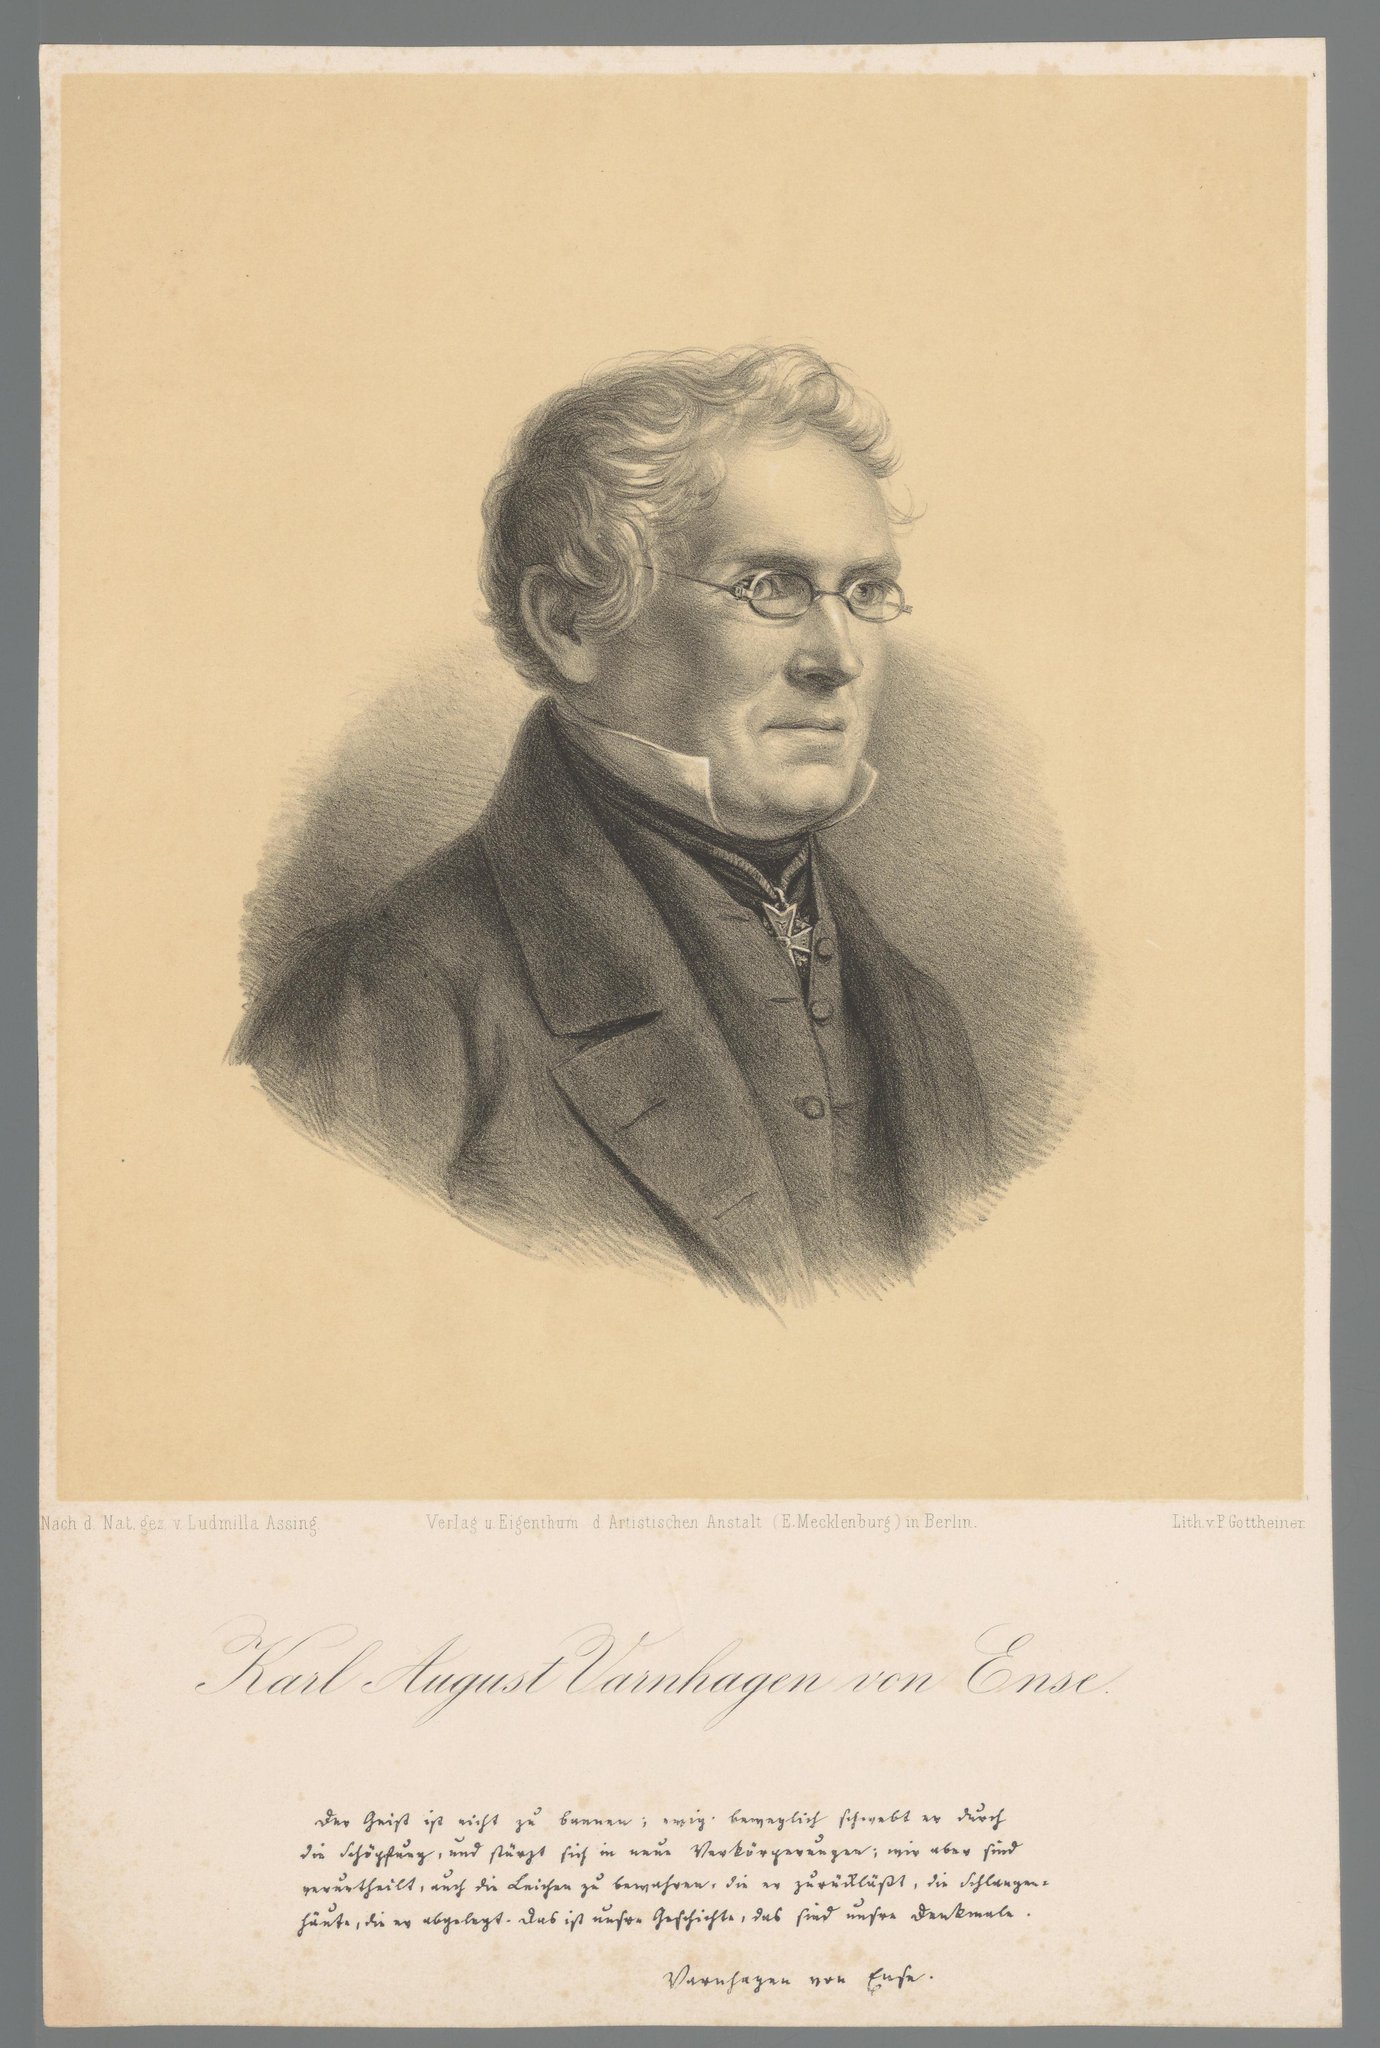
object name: print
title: Portret van Karl August Varnhagen von Ense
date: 1831-1880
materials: paper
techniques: lithograph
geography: berlin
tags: historical persons, diplomacy, diplomat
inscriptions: collector's mark: Lugt 2228